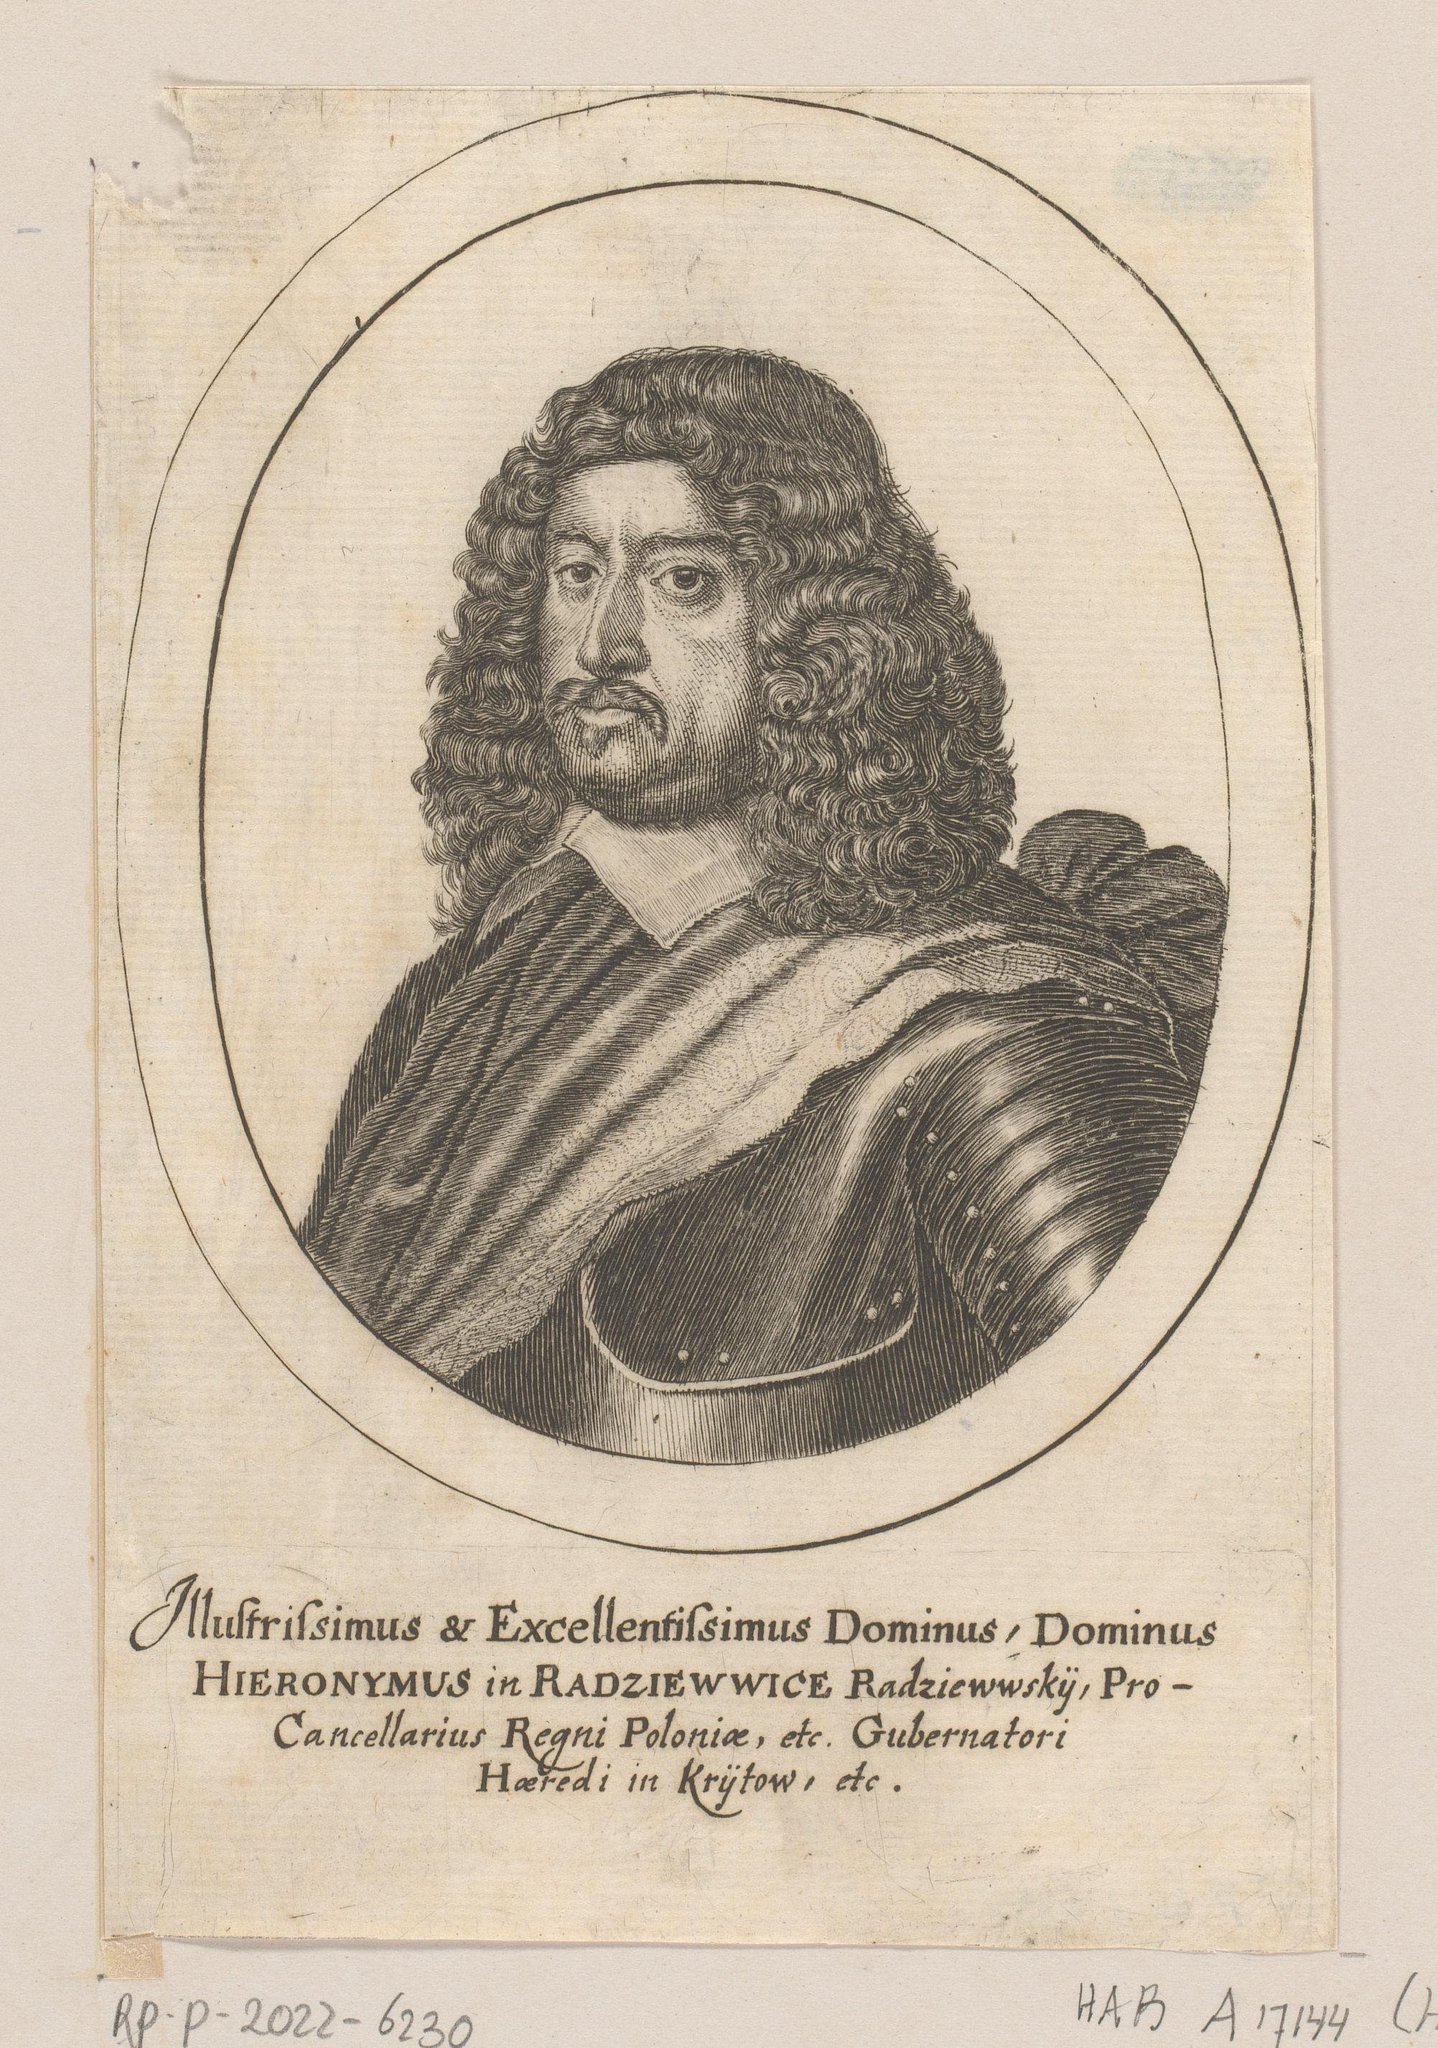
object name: print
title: Portret van Hieronim Radziejowski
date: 1663-1685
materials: paper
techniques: engraving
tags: governmental and representative bodies, commander-in-chief, general, marshal, historical persons, diplomacy, diplomat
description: Prent waarschijnlijk uit: Schleder, Johann Georg. Theatrum Europaeum. Frankfurt am Main: erven Matthäus Merian, 1663, dl. 7. Komt mogelijk ook voor in de tweede druk uit 1685.